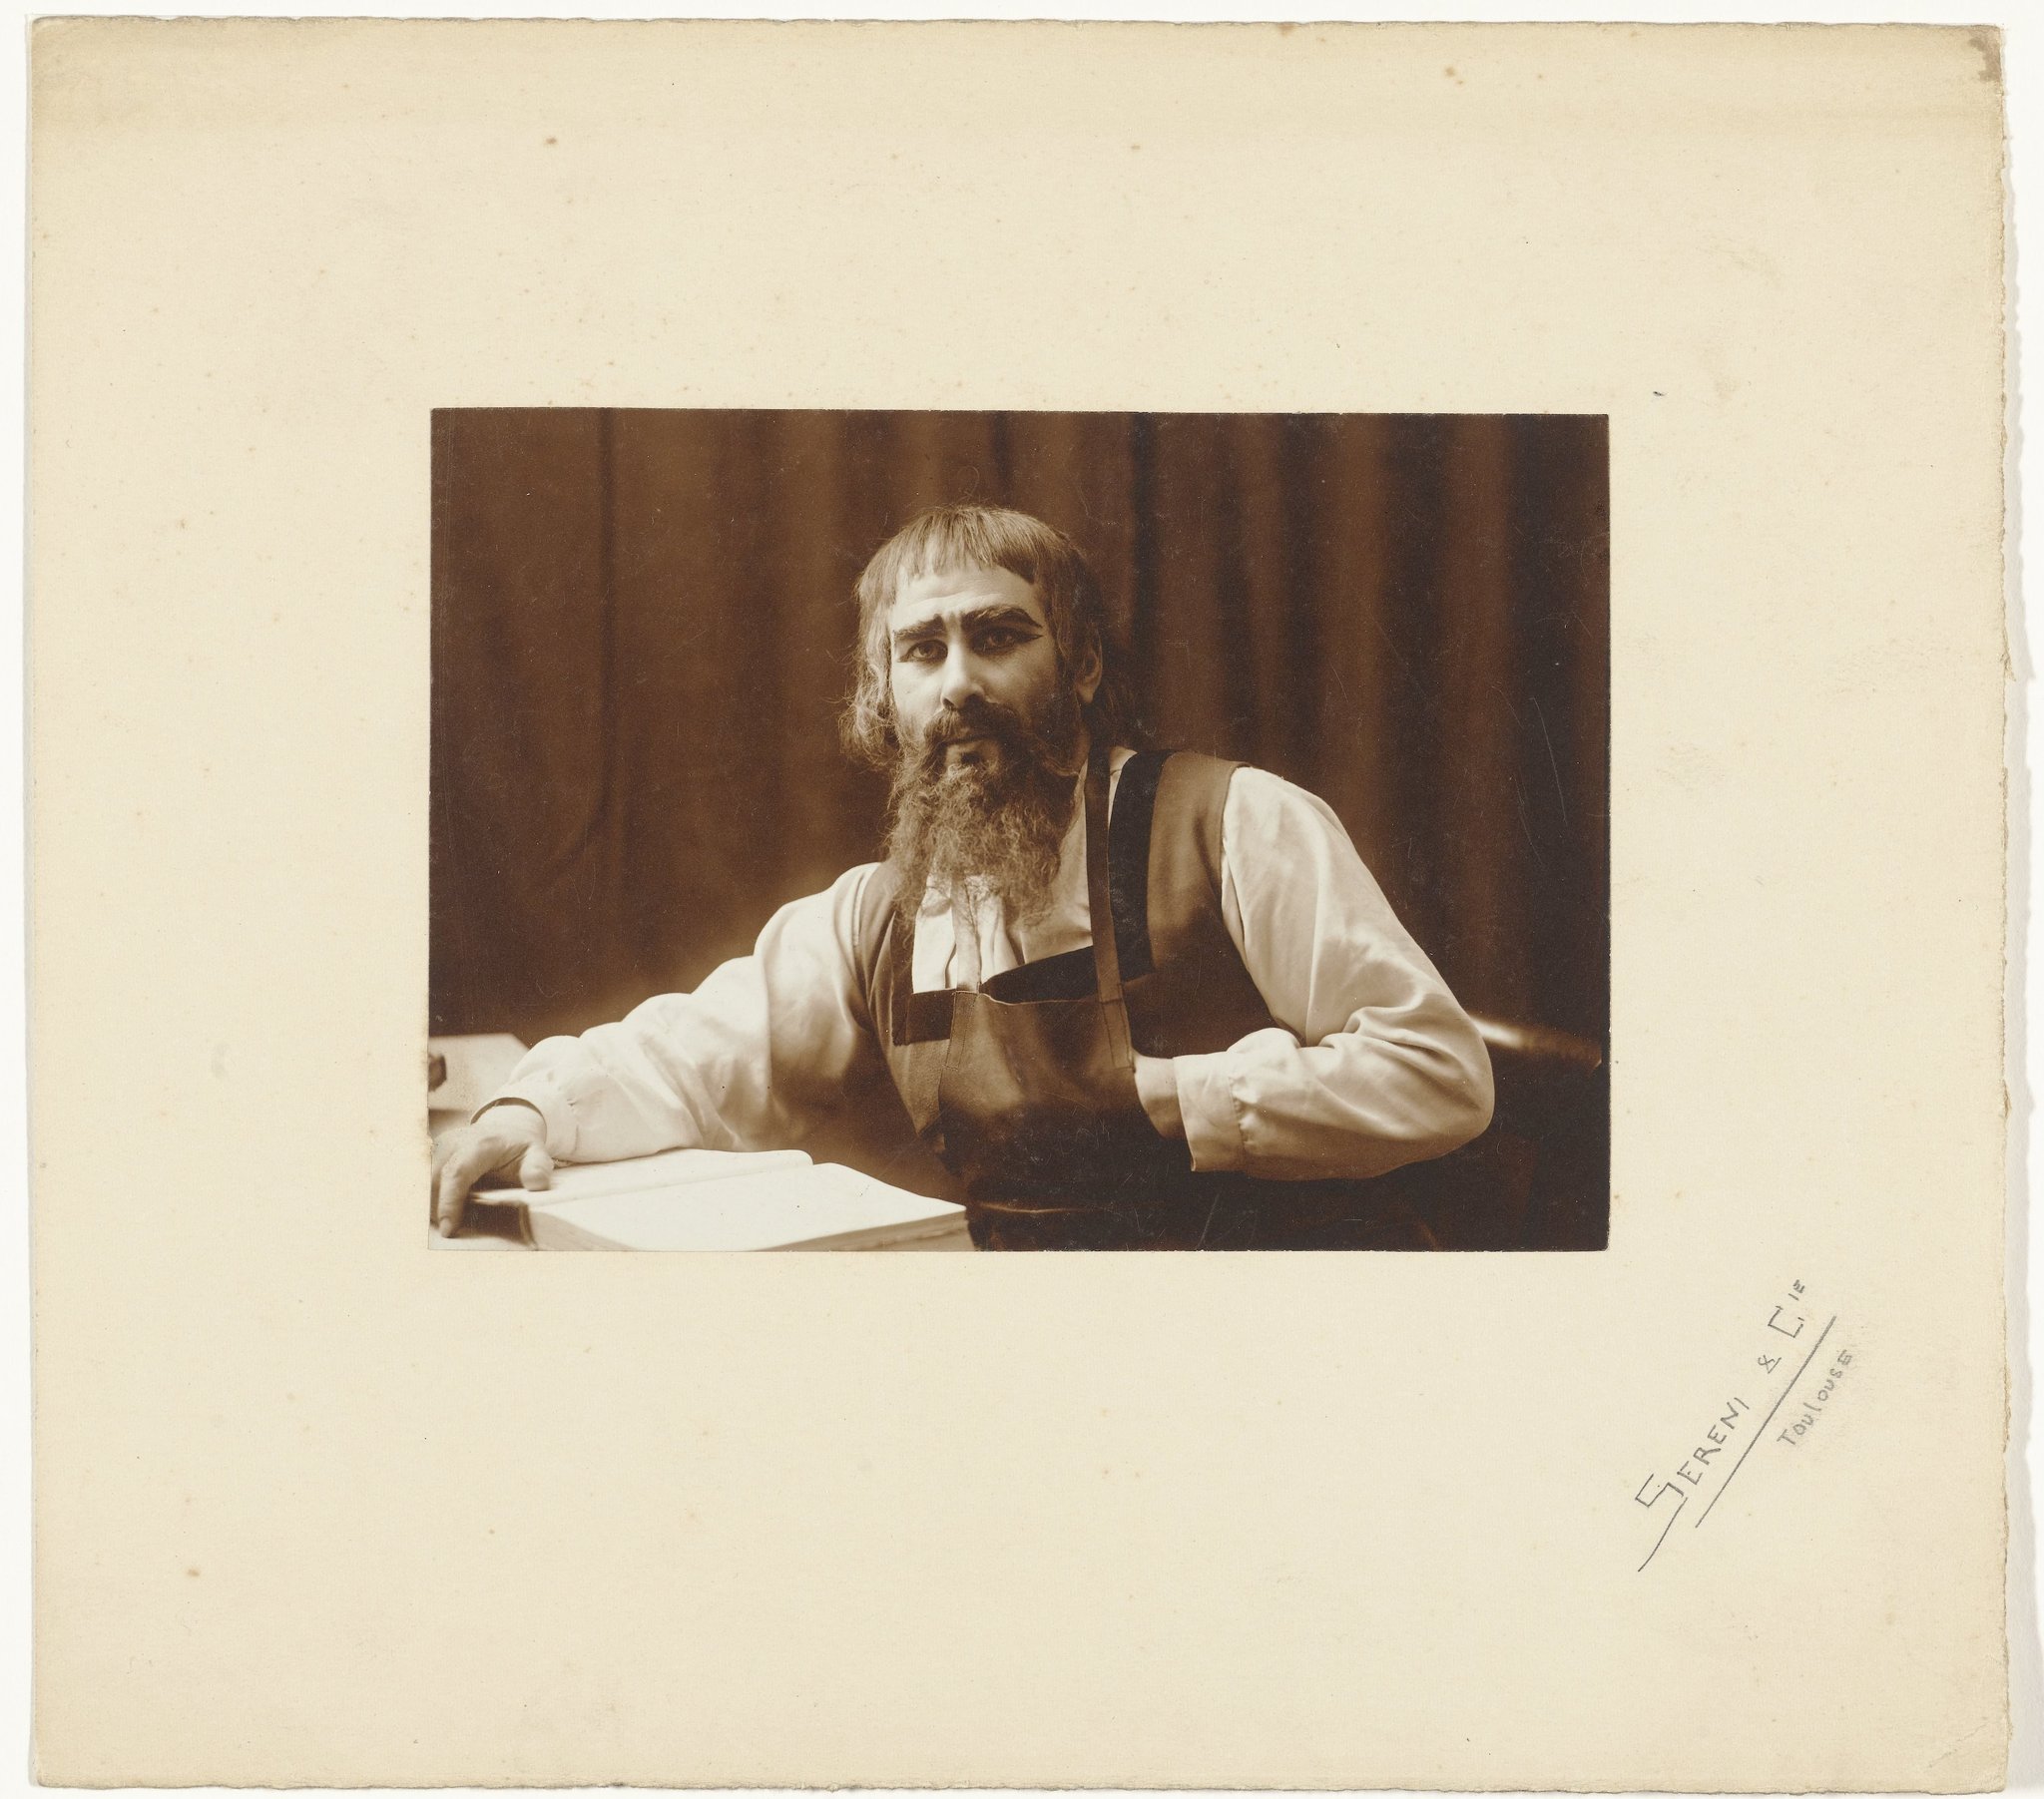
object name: photograph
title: Portret van een onbekende acteur met boezeroen en een boek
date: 1900-1920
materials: paper, cardboard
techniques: gelatin silver print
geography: toulouse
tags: portrait of actor, actress, historical persons not known by name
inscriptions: signature: ‘Sereni & Cie/ Toulouse’